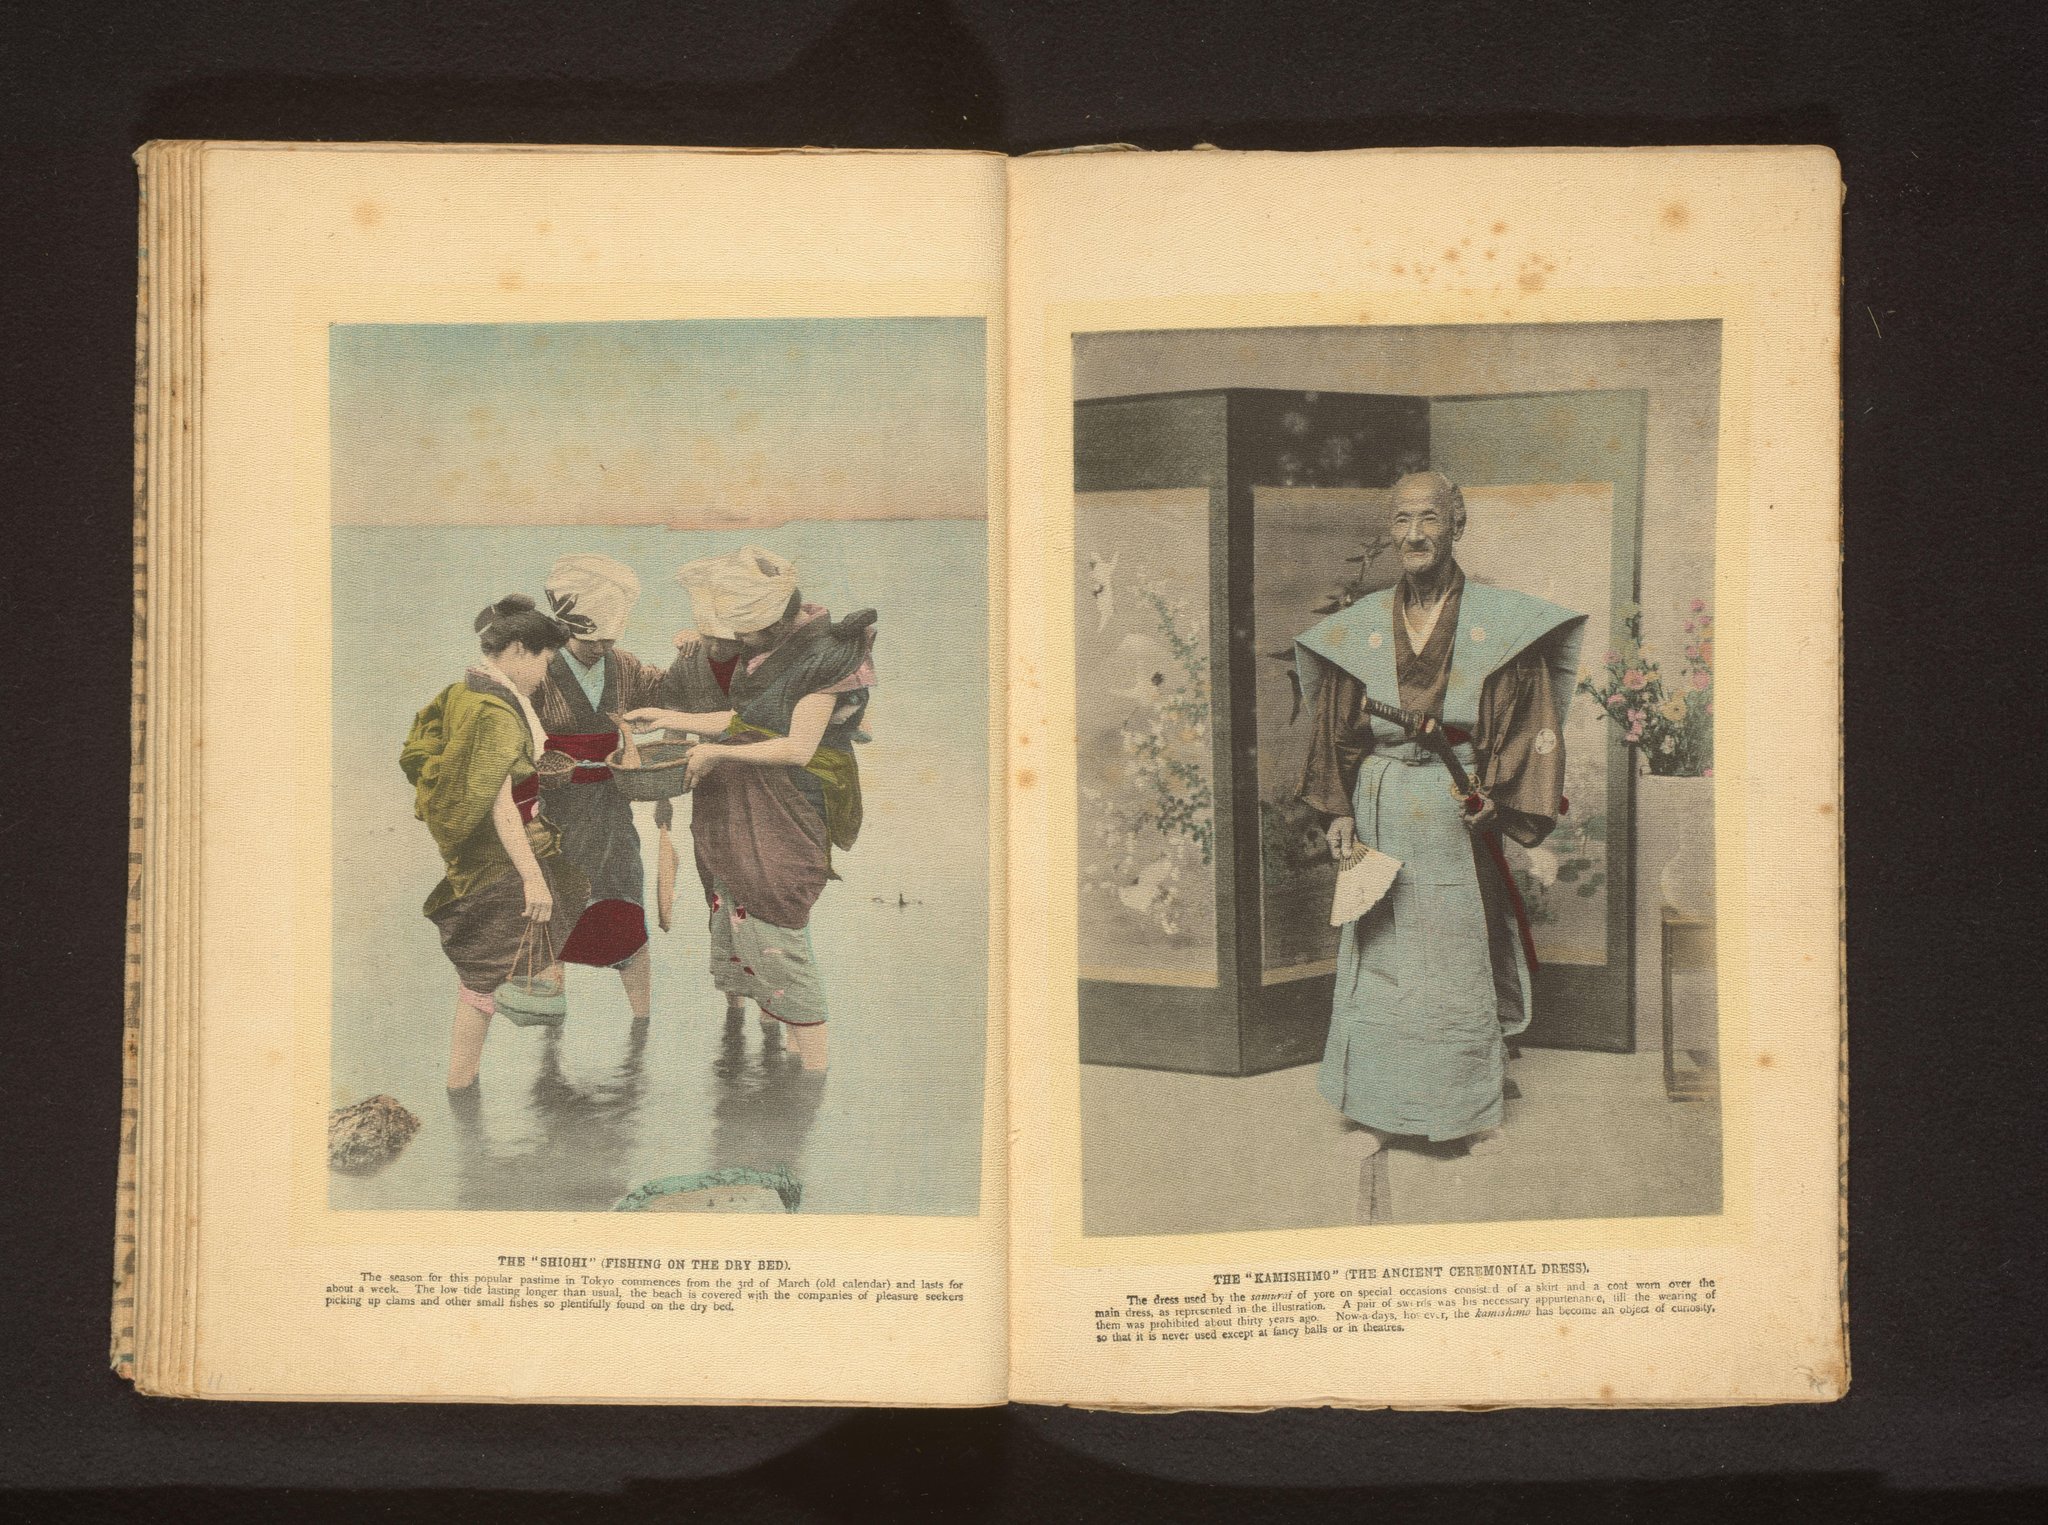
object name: page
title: The "kamishimo" (the ancient ceremonial dress)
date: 1886-1896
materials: paper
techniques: photograph, hand coloring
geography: japan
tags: old man, interior ~ representation of a building, dress, gown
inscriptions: inscription: ‘The dress used (...) or in theatres.’